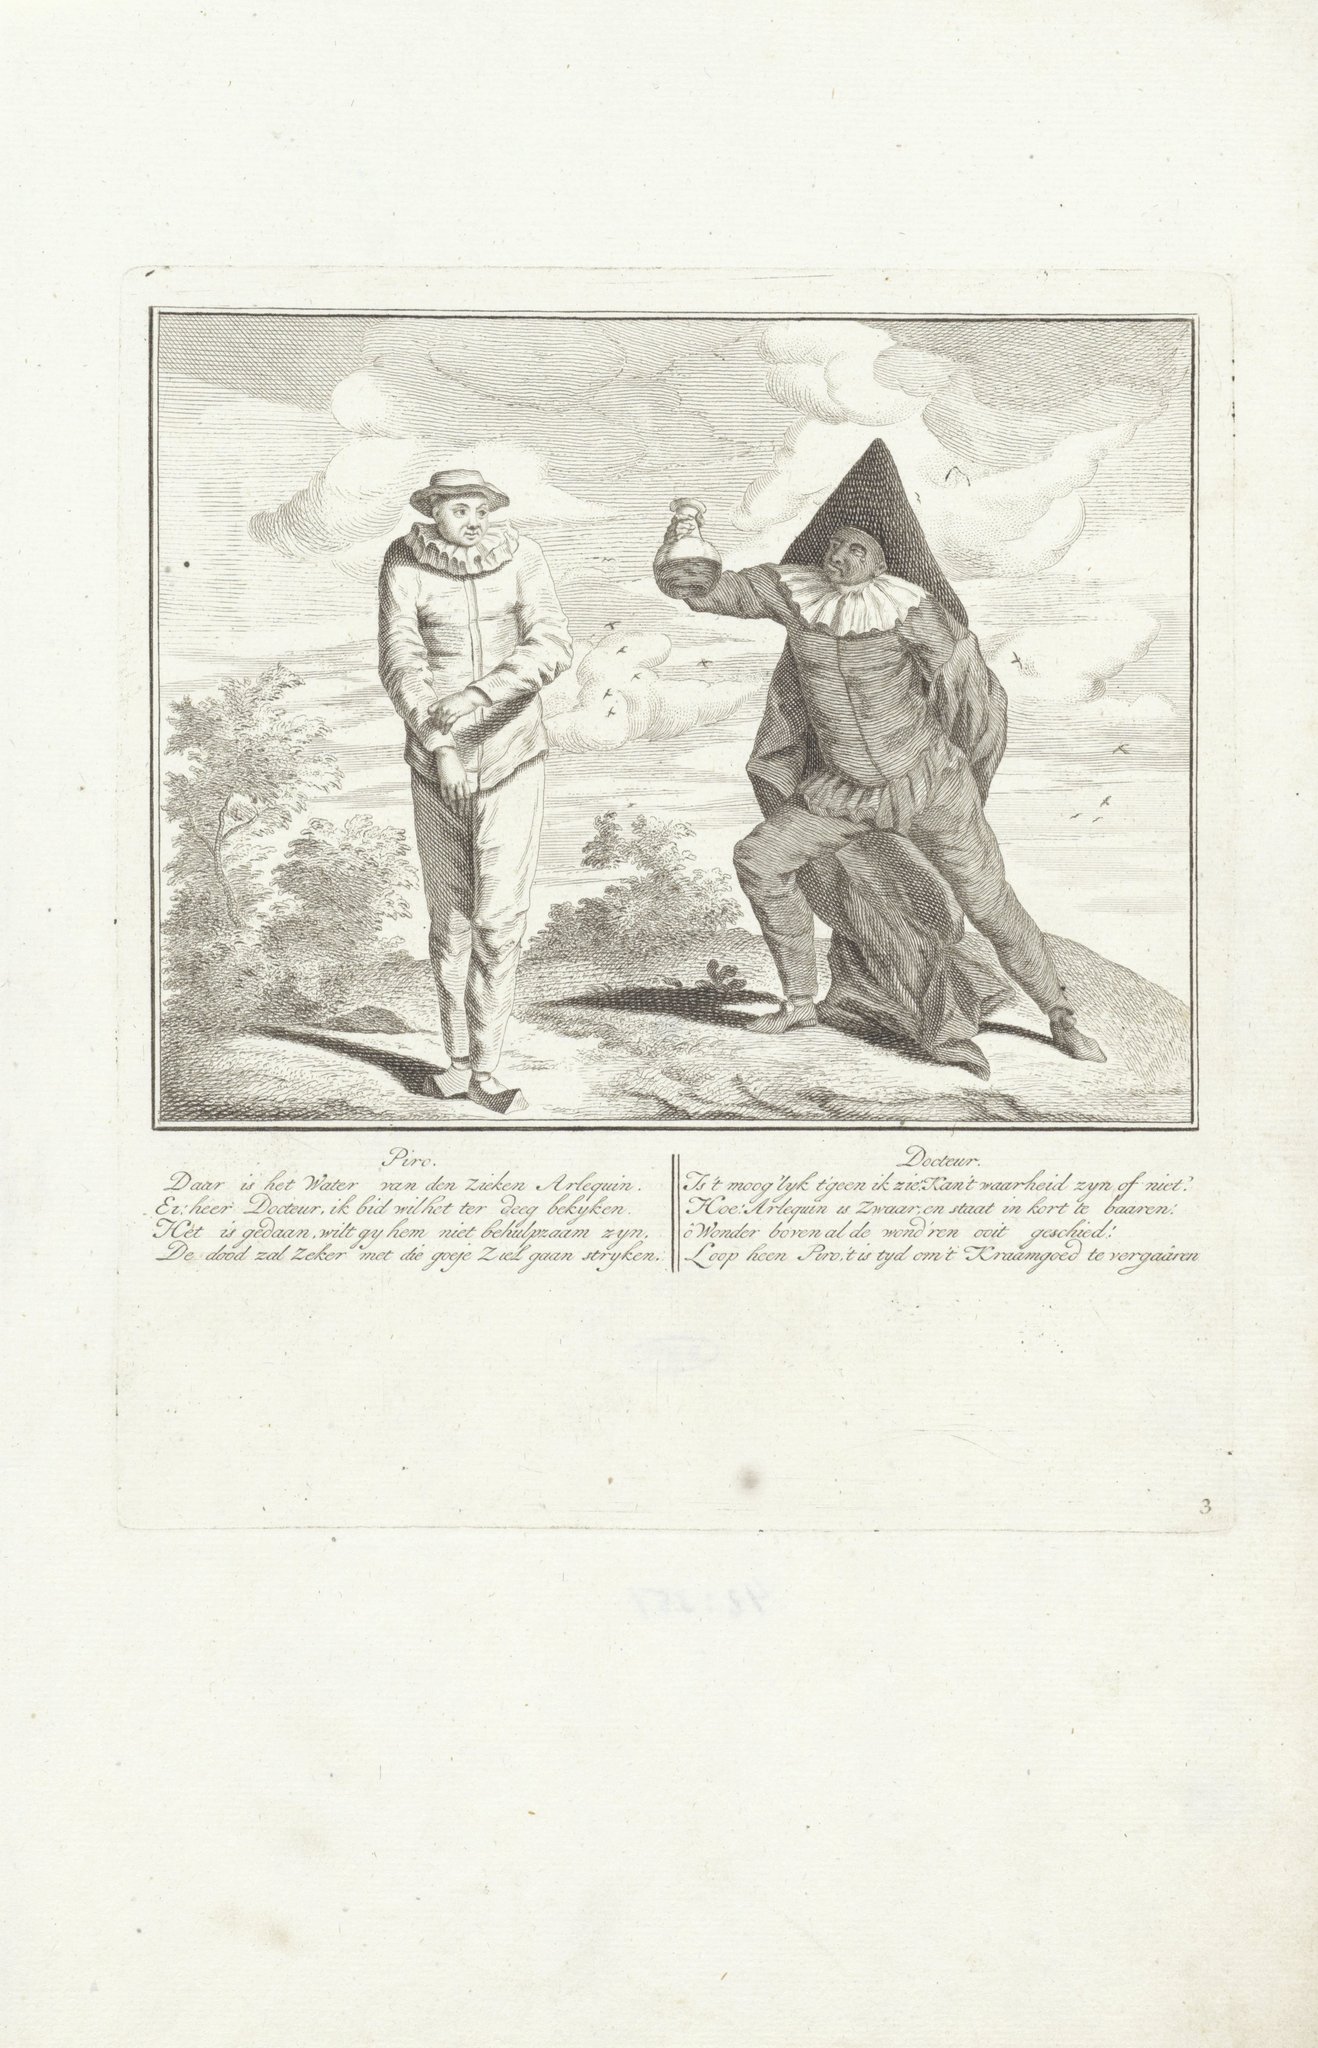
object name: print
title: Het nieuw geopend Italiaans Toneel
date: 1720-1728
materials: paper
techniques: engraving, etching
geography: amsterdam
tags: types in 'commedia dell'arte', examination of urine, types in 'commedia dell'arte': harlequin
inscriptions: collector's mark: Lugt 2228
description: Piro heeft de dokter de urine van Arlequin gegeven om deze te onderzoeken. De dokter kijkt in de urinaal terwijl Piro afwacht.